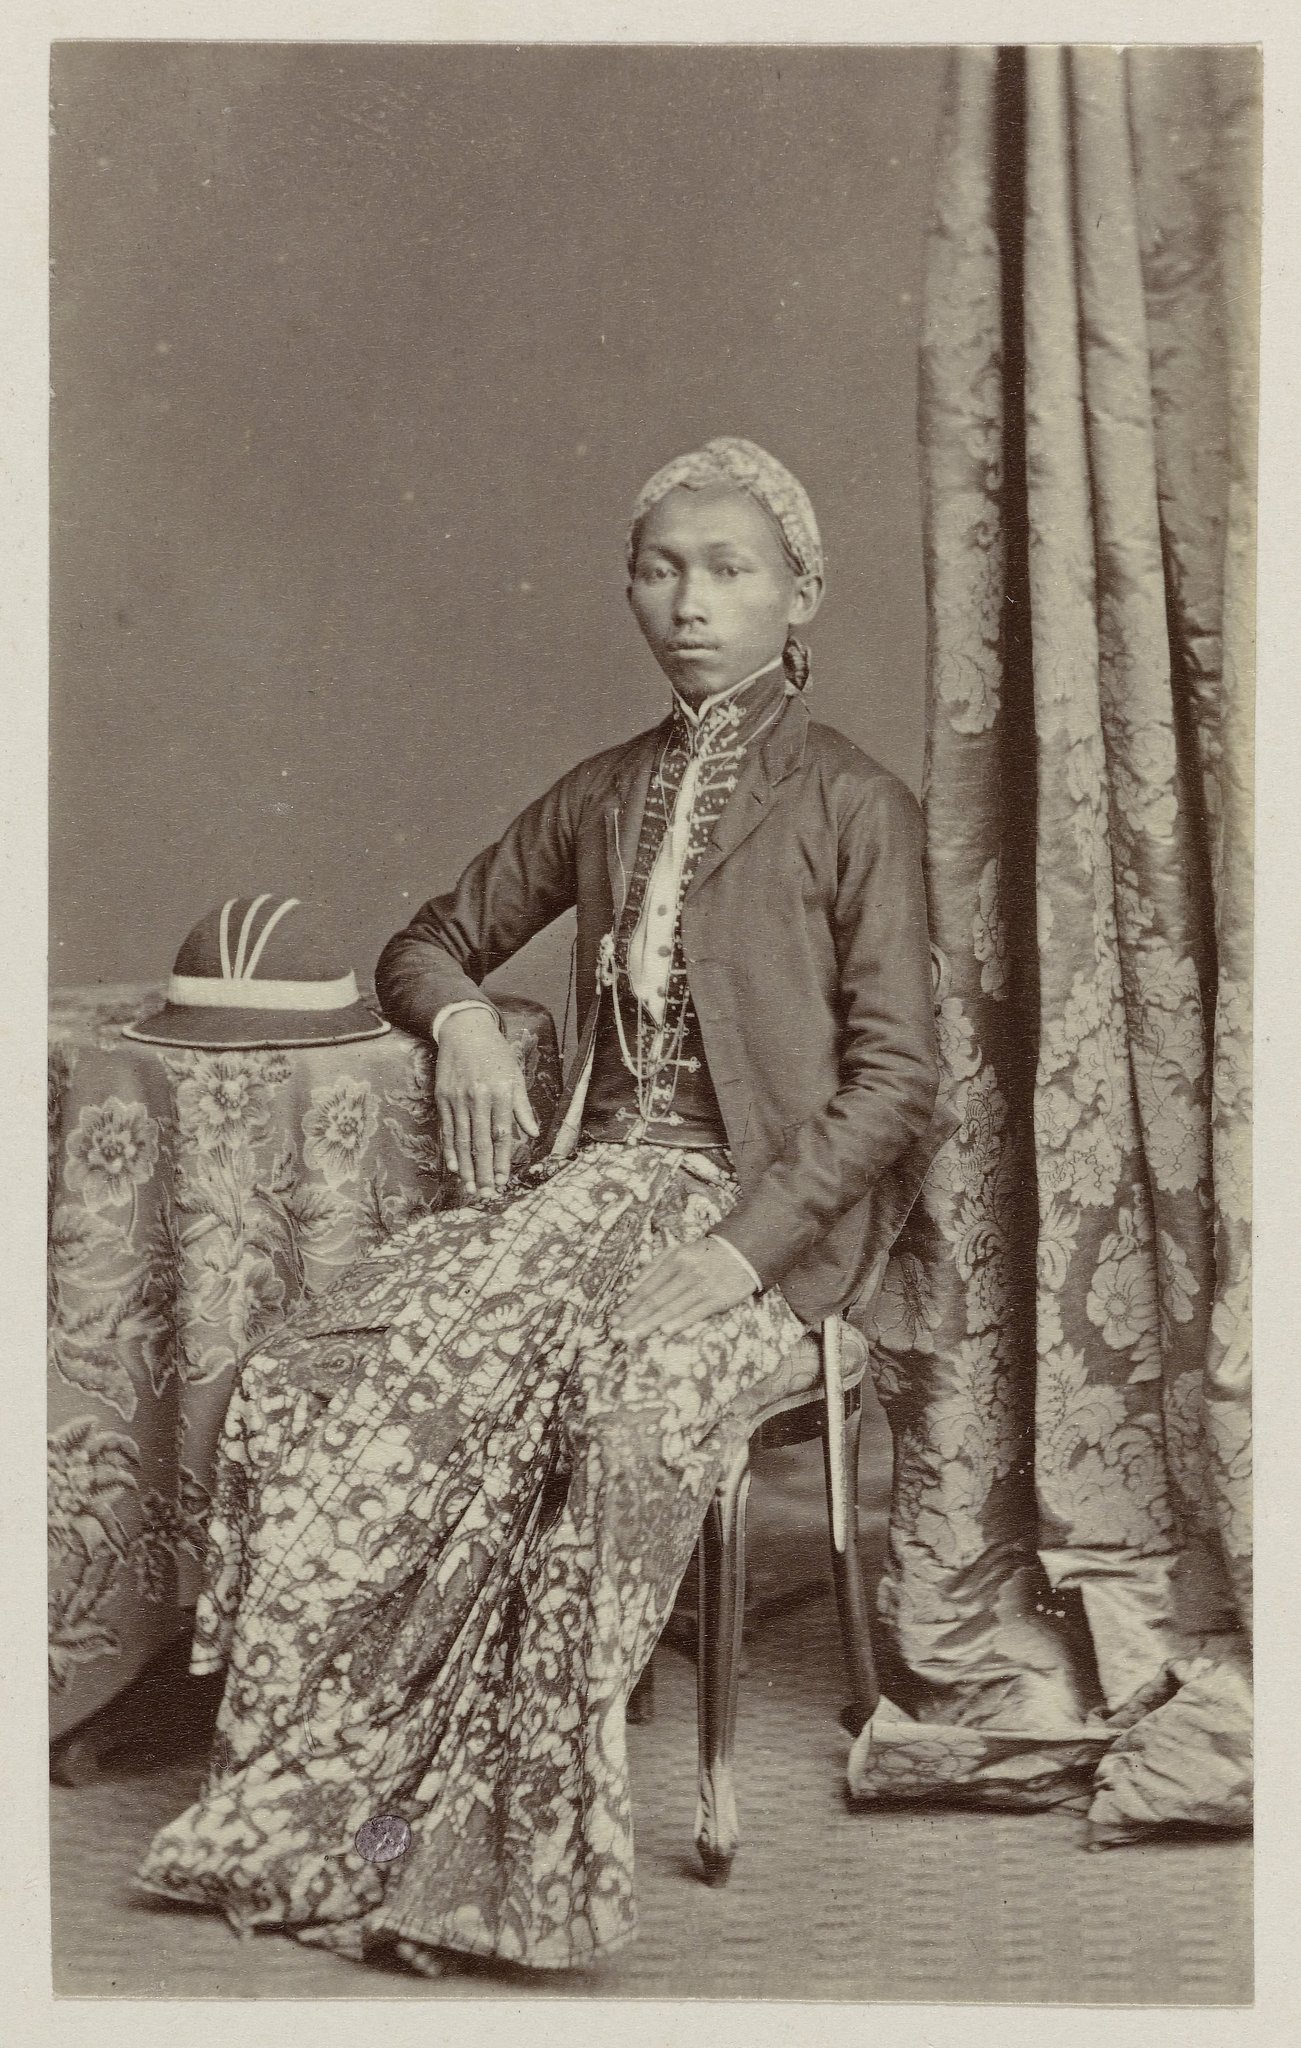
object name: photograph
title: Portret van een regent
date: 1860-1890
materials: photographic support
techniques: albumen print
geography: celebes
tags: historical persons not known by name, java, batavia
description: Studioportret van een regent, zittend bij een tafeltje. Ingeplakte foto in het fotoalbum getiteld: Gezichten van Java.